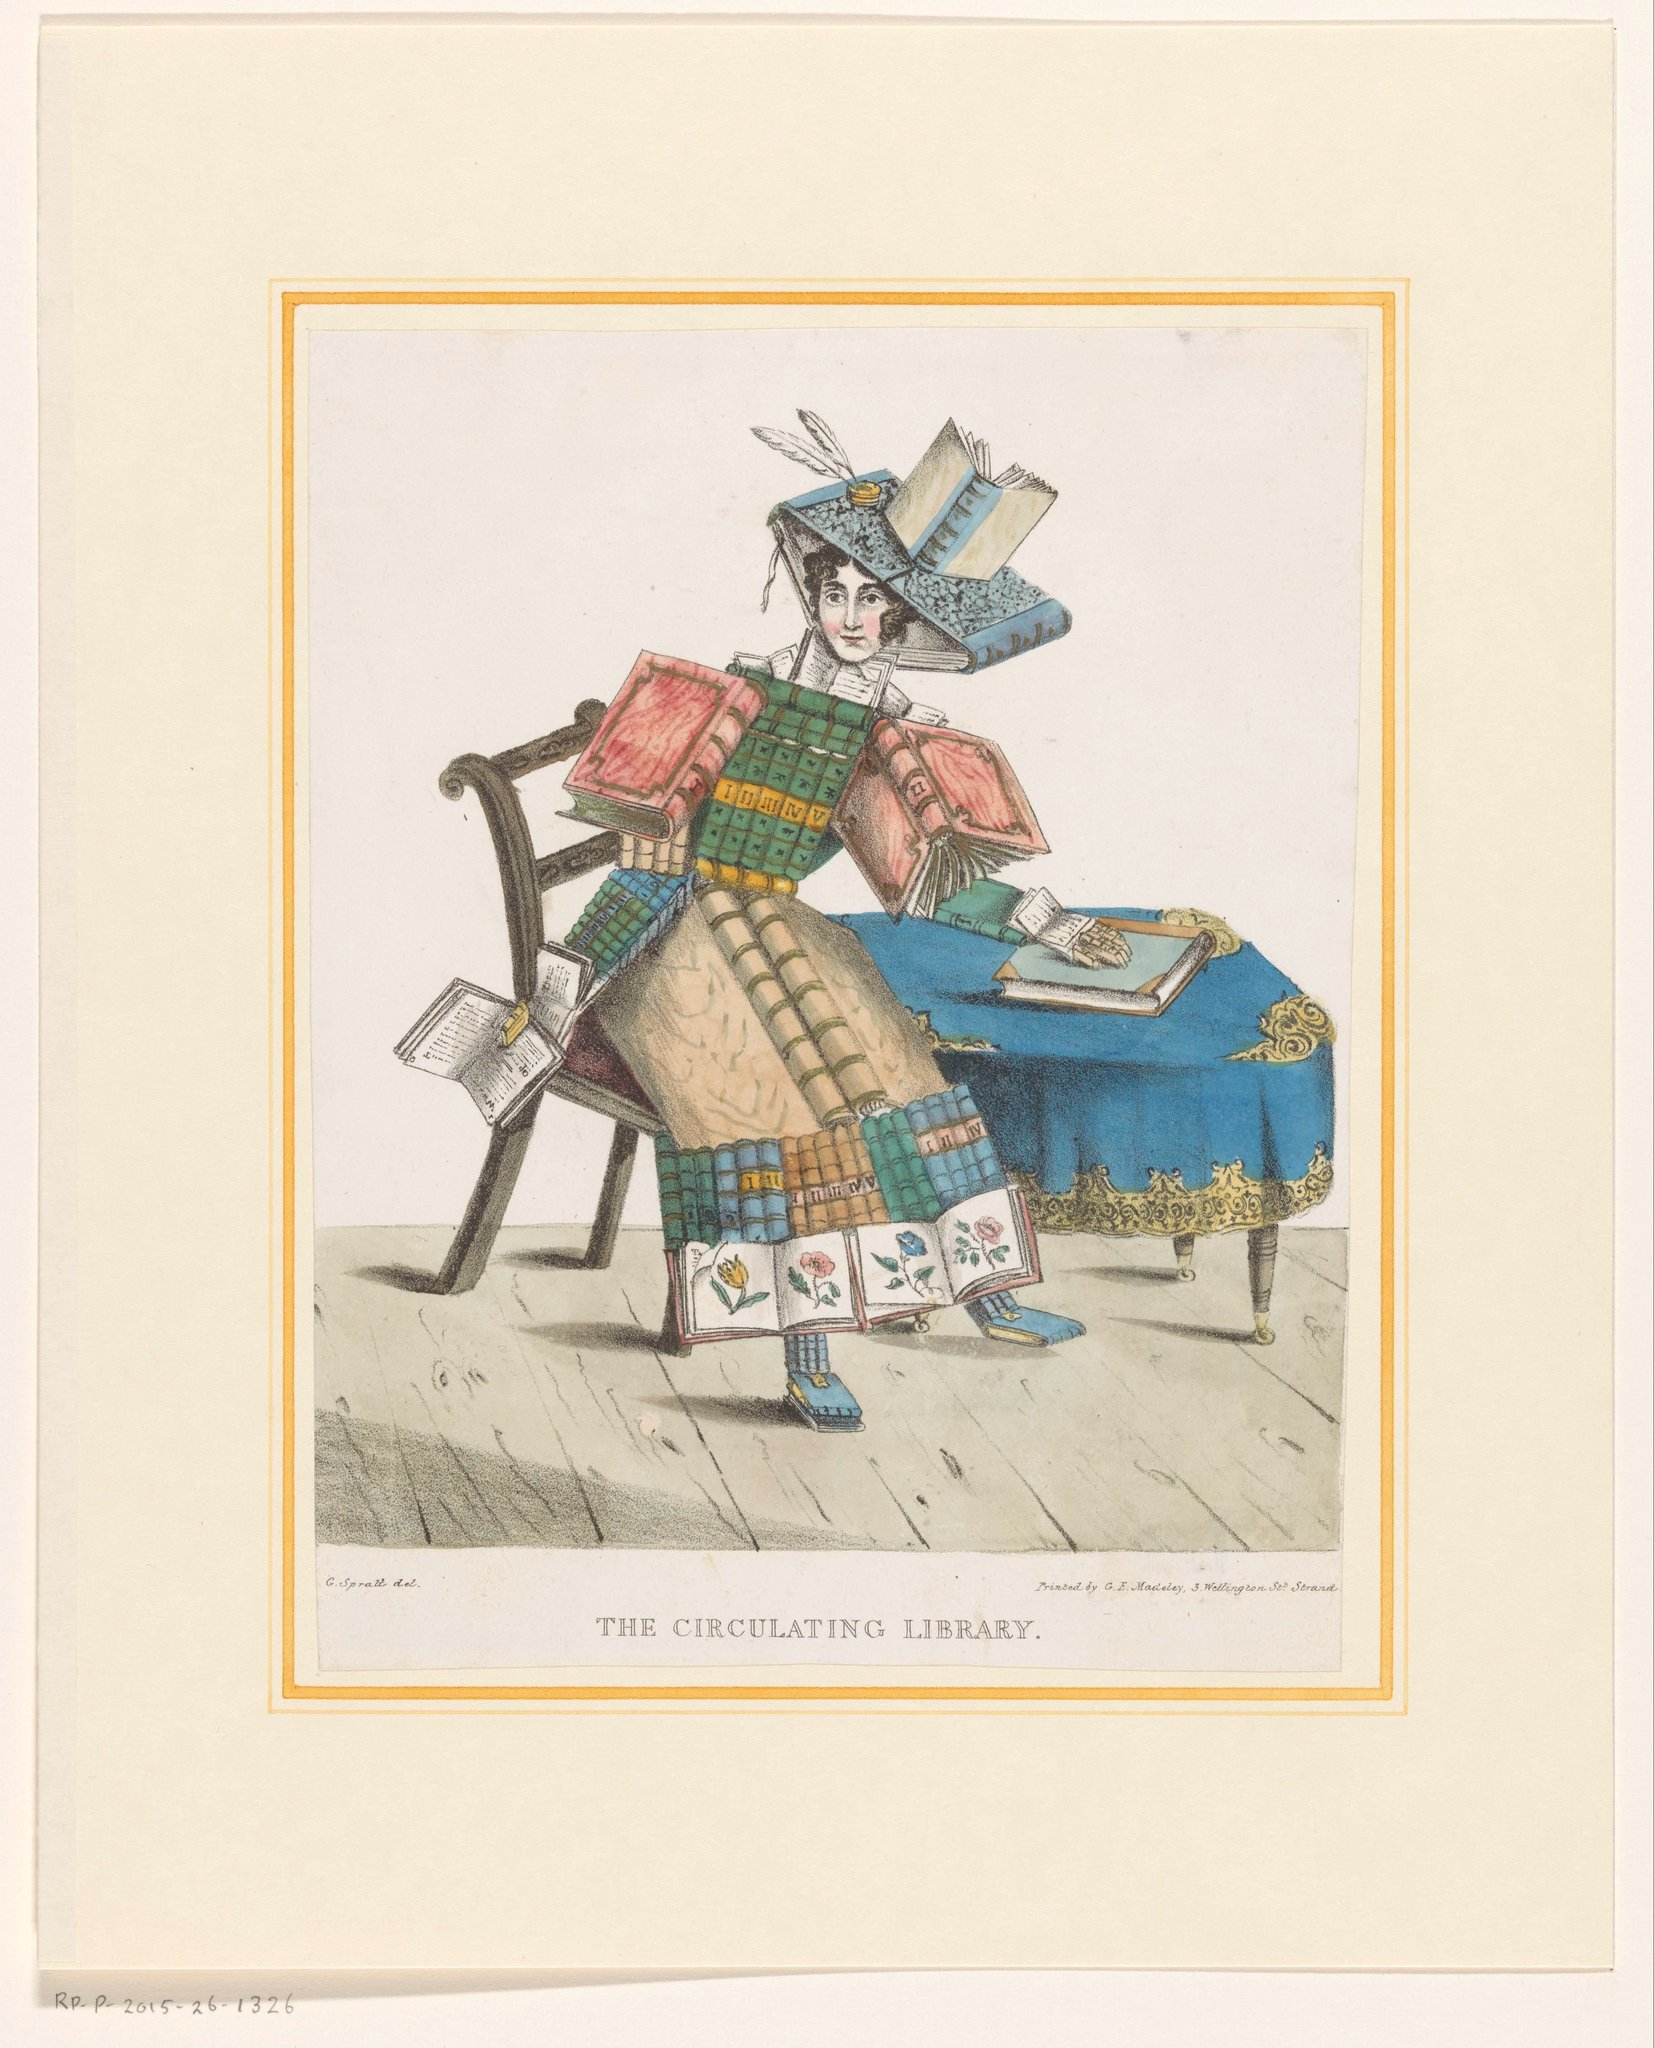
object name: print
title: Vrouw met een lichaam opgebouwd uit boeken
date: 1830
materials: paper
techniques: hand coloring, lithograph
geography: london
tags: ink-well, book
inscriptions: collector's mark: Lugt 2228, collector's mark: Lugt 4779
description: Een vrouw met een lichaam bestaande uit boeken van verschillend formaat, zittend op een stoel naast een tafel. In haar rechterhand houdt zij een opengeslagen boek, haar linkerhand rust op een boek dat op de tafel ligt.